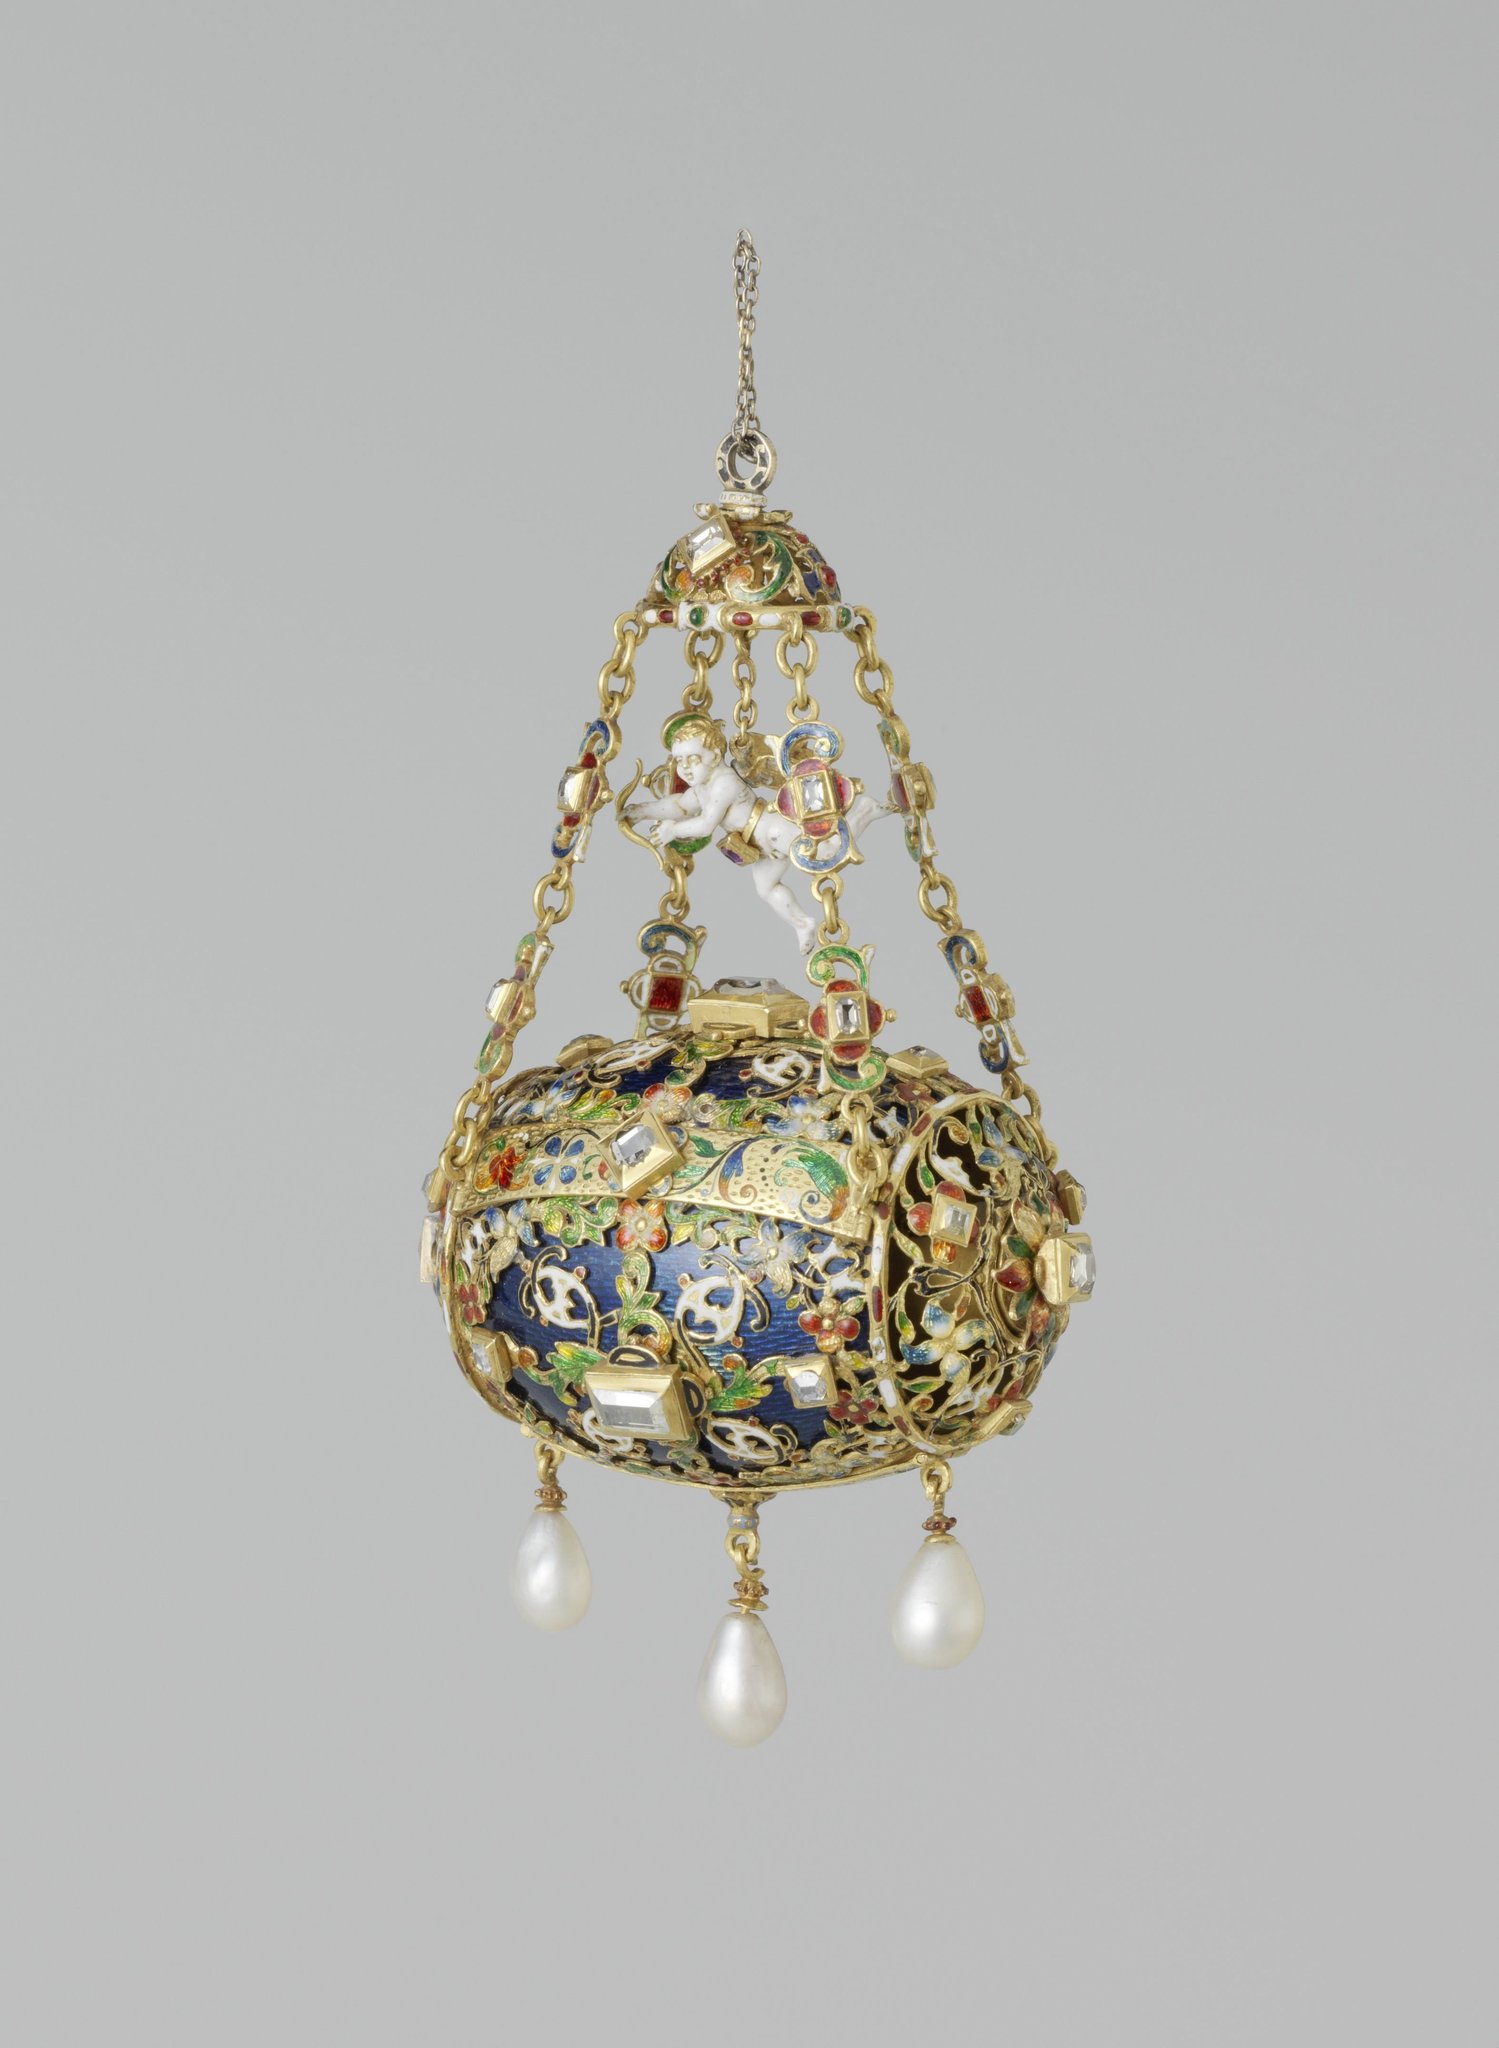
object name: pendant jewelry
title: Hanger in de vorm van een reukbal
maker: Anonymous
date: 1550-1600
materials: gold, pearl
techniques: enameling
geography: germany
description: Pendant, pomander. Gold, gems, pearls and enamel. Germany, c. 1550-1600.